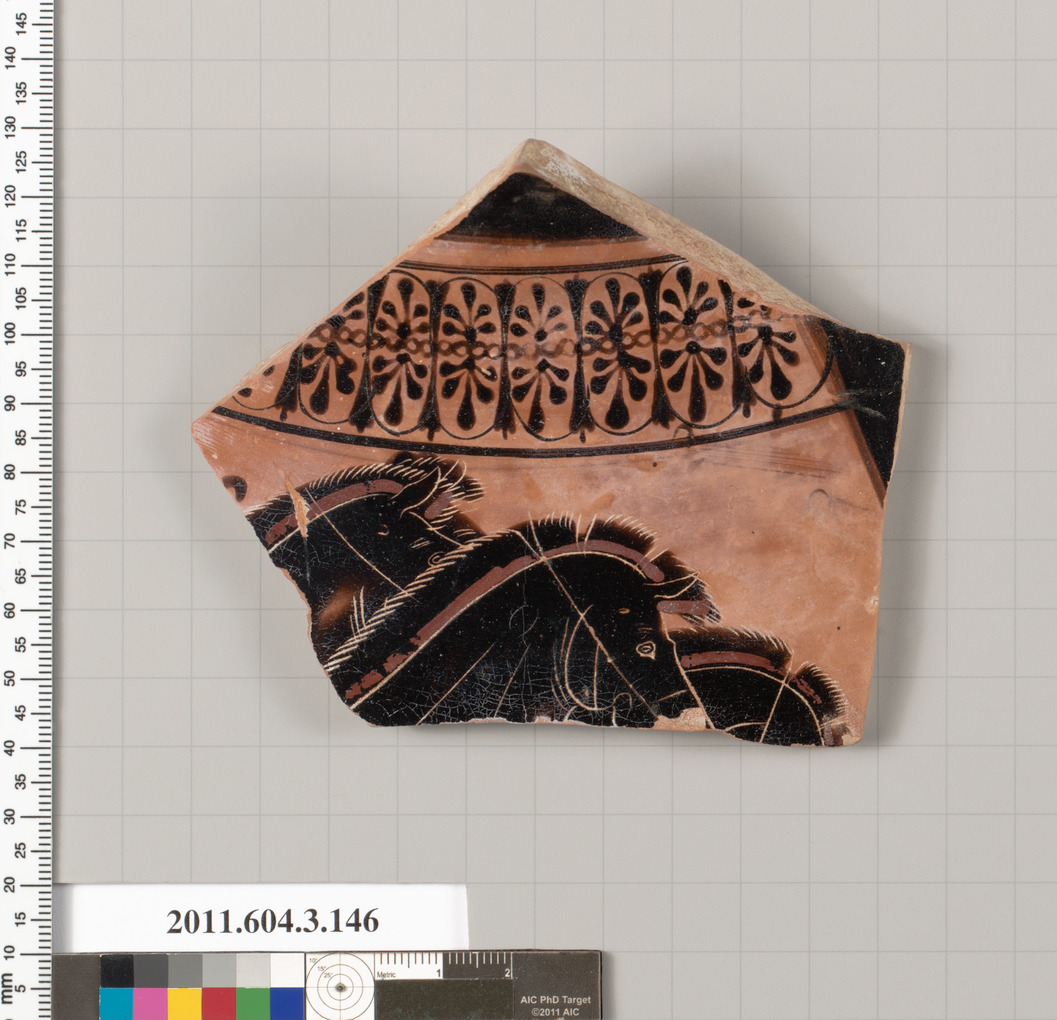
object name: amphora fragment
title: Terracotta fragment of an amphora (jar)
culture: greek, attic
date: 510 BCE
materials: terracotta